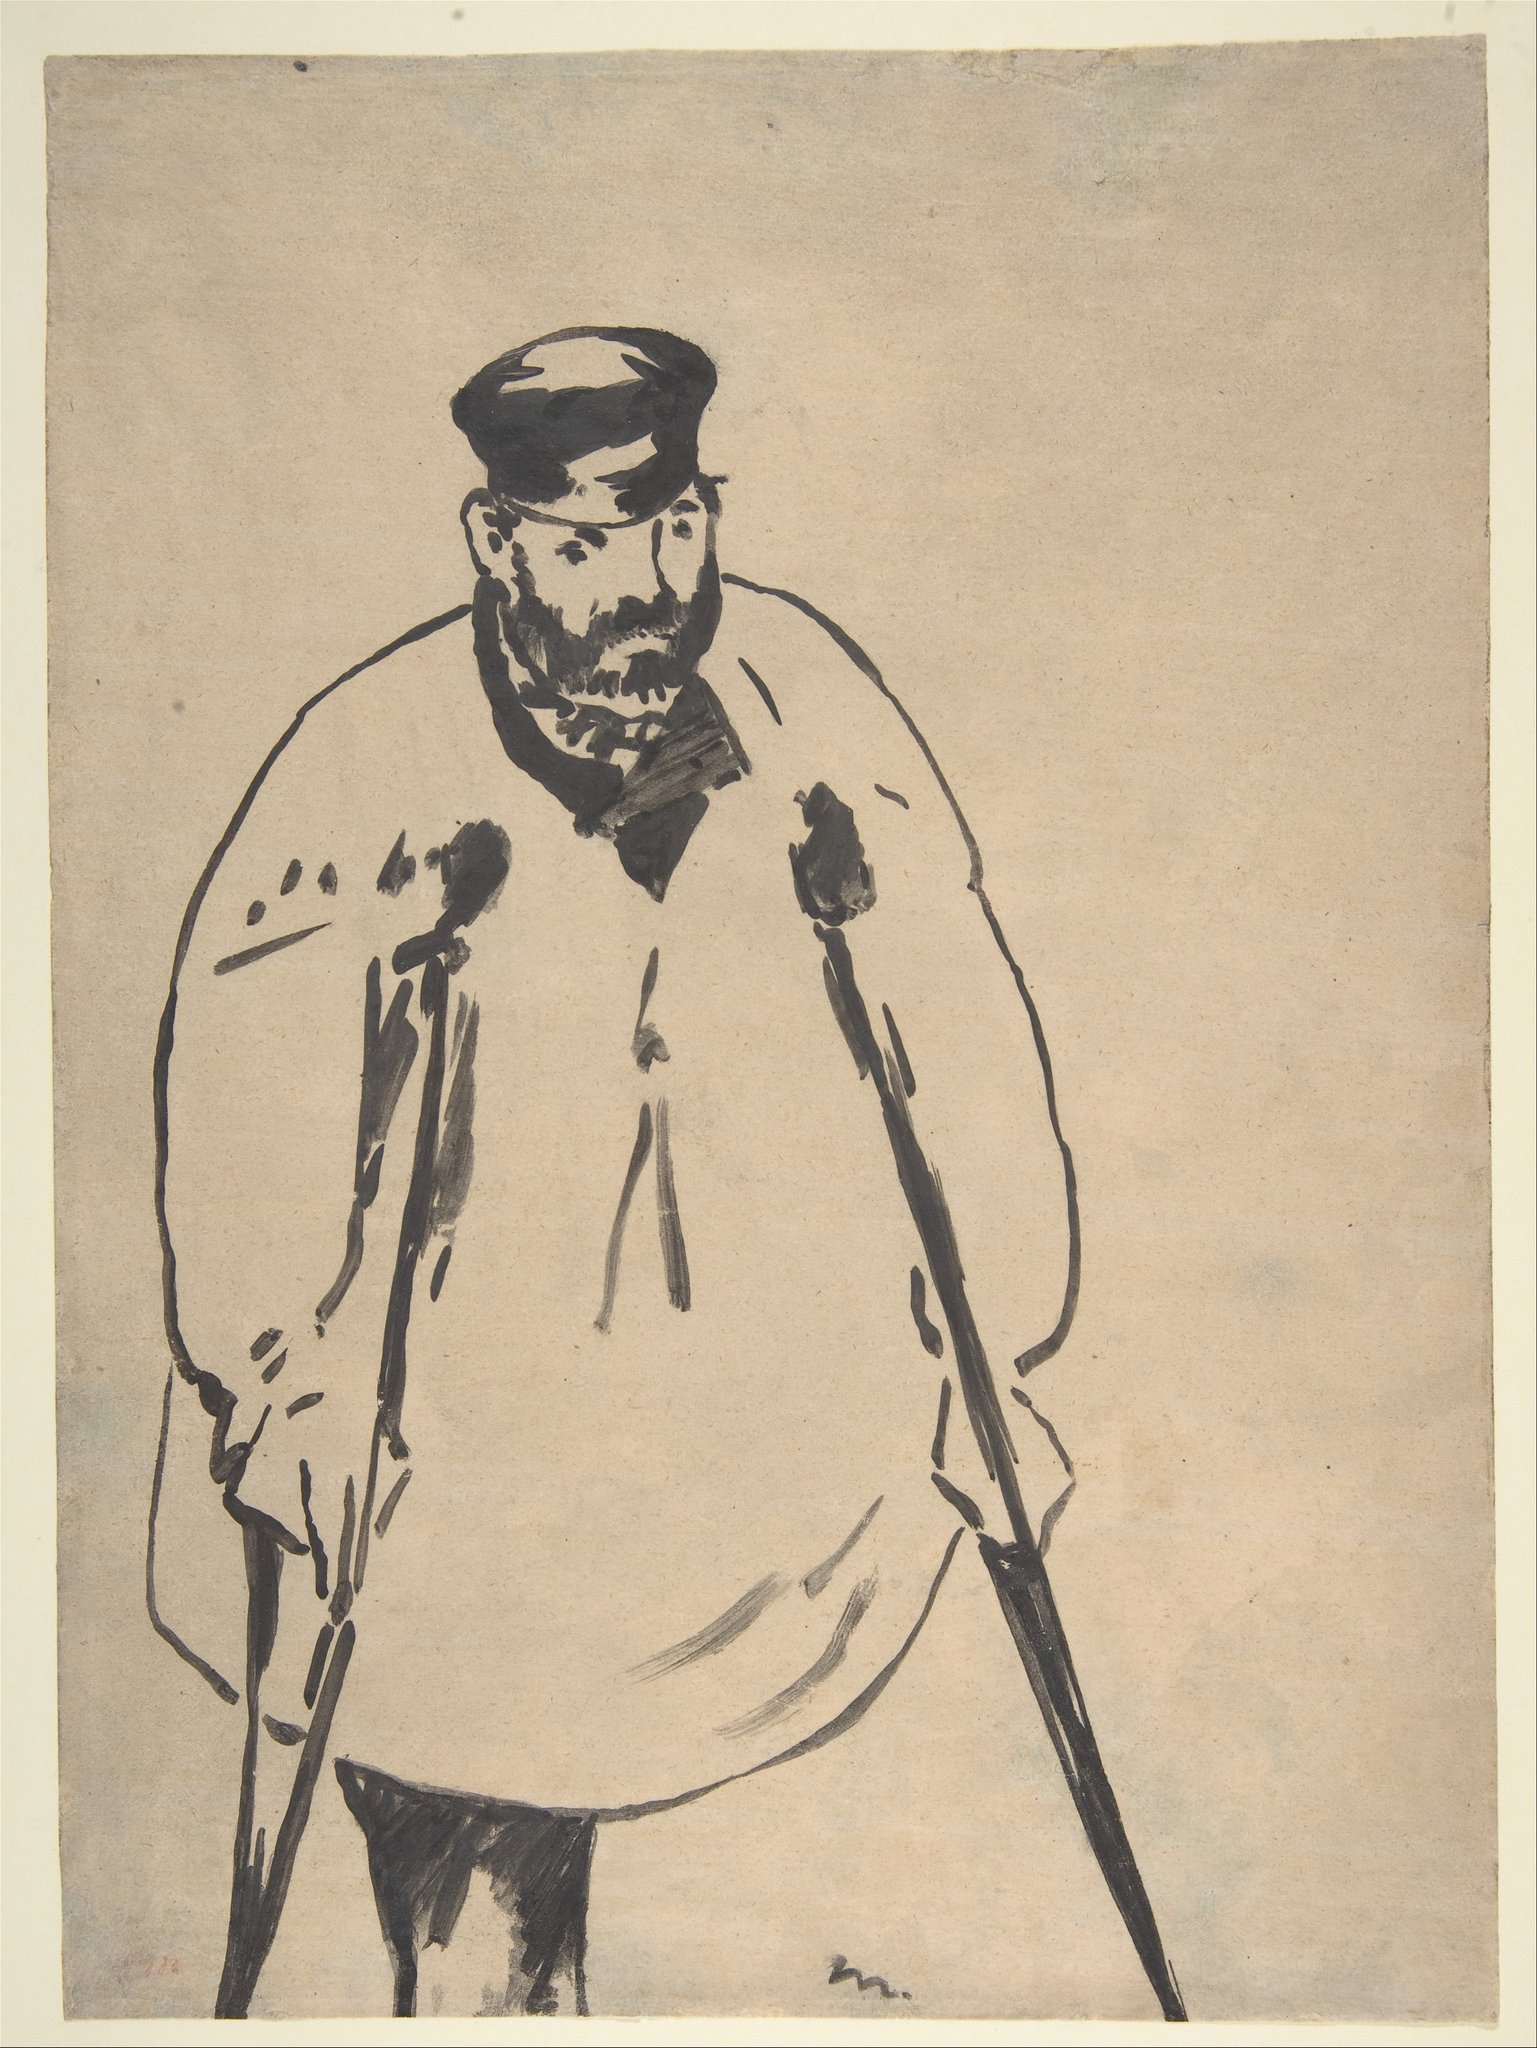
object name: drawing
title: A Man on Crutches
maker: édouard manet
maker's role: artist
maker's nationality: french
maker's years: 1832-1883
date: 1878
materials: ink, paper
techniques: brush, lithograph, transfer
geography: france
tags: men